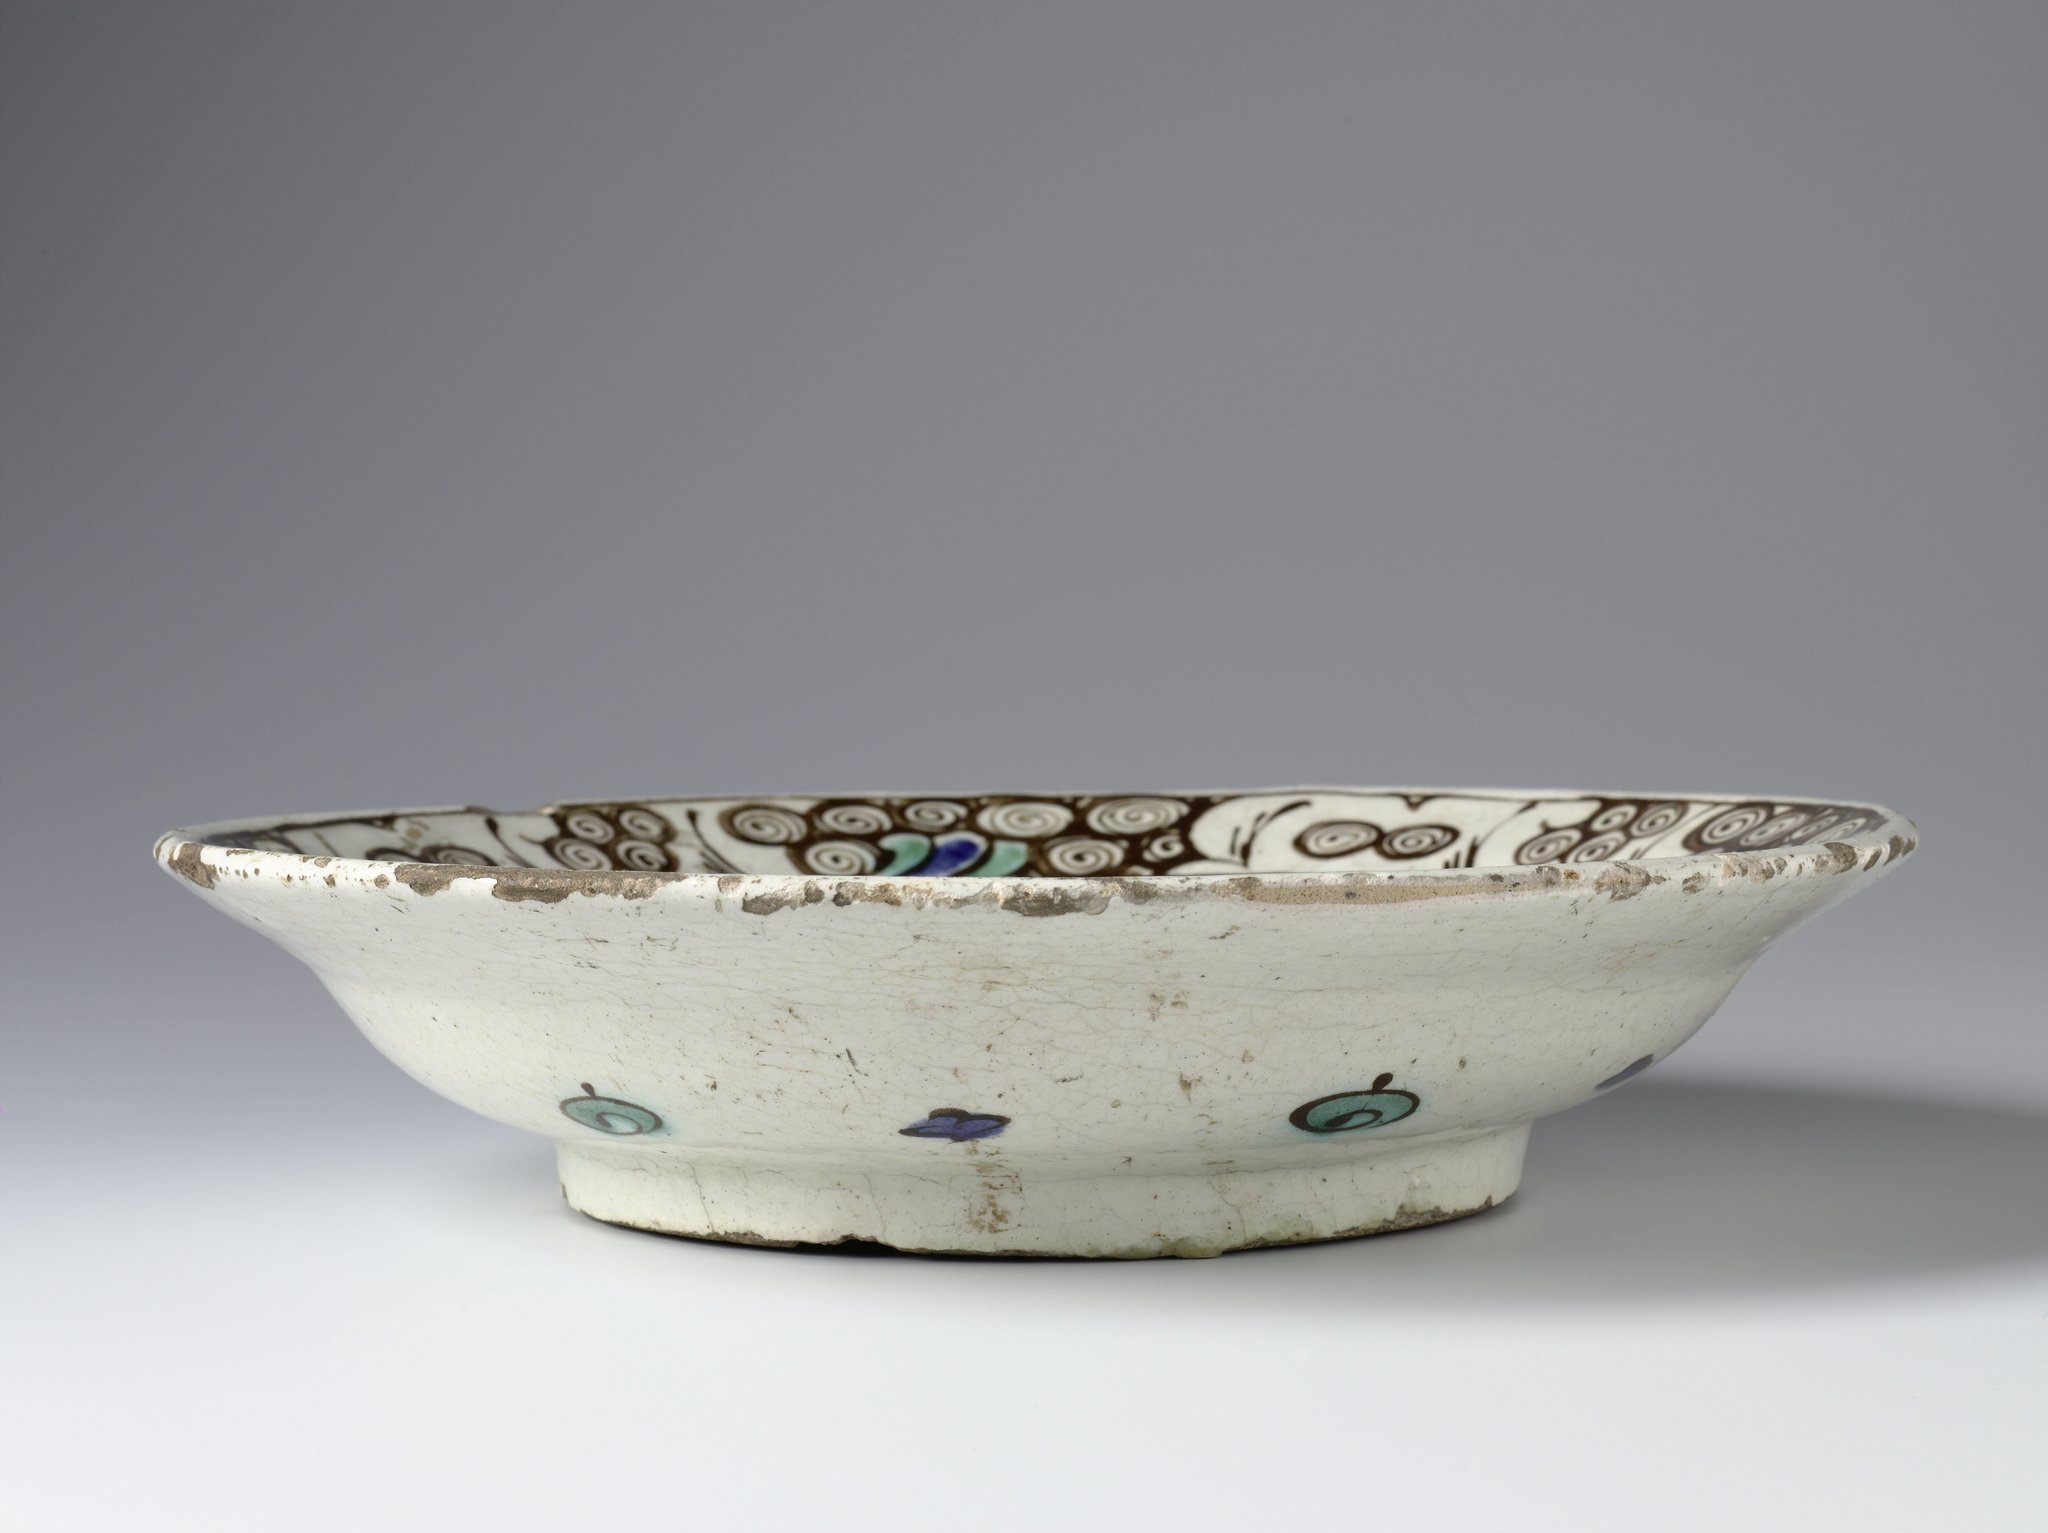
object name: platter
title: dish with flowering plants and scrolls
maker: Anonymous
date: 1600-1649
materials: earthenware, glaze, quartz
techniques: firing, turning, vitrification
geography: iznik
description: Schotel van kwarts-fritgoed, beschilderd in onderglazuur blauw, rood, groen en zwart. Op het plat een gestileerde bloeiende plant. De rand met krulwerk. Iznik.